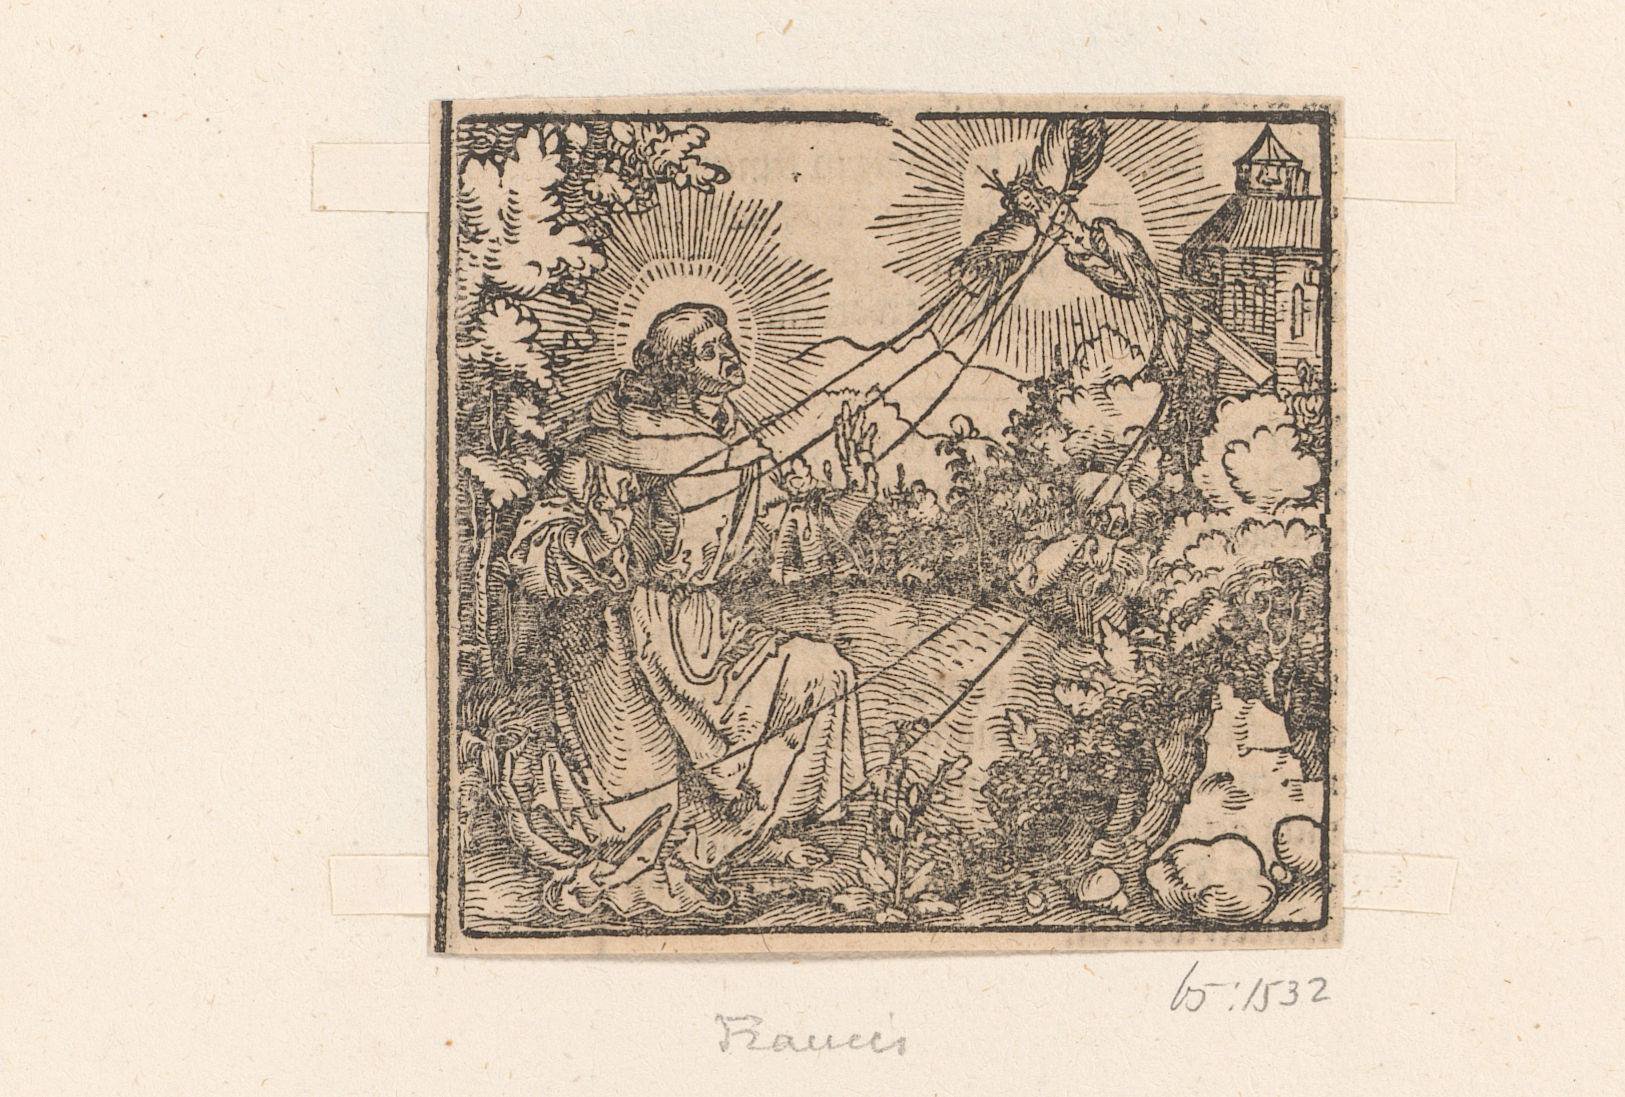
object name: album leaf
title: Stigmatisatie van de Heilige Franciscus van Assisi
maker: Anonymous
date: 1500-1536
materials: paper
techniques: woodcut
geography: germany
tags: stigmatization of st. francis of assisi: in retreat on mount alverna, he beholds a vision of christ on the cross enveloped by wings (like a seraph with six wings); rays passing down to the body of the kneeling saint form the marks of the five wounds of christ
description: Franciscus, in gebed op de berg Monte Alverna, heeft een visioen van Christus als een serafijn op het kruis. Hij ontvangt de stigmata van Christus. Prent maakt deel uit van een album.